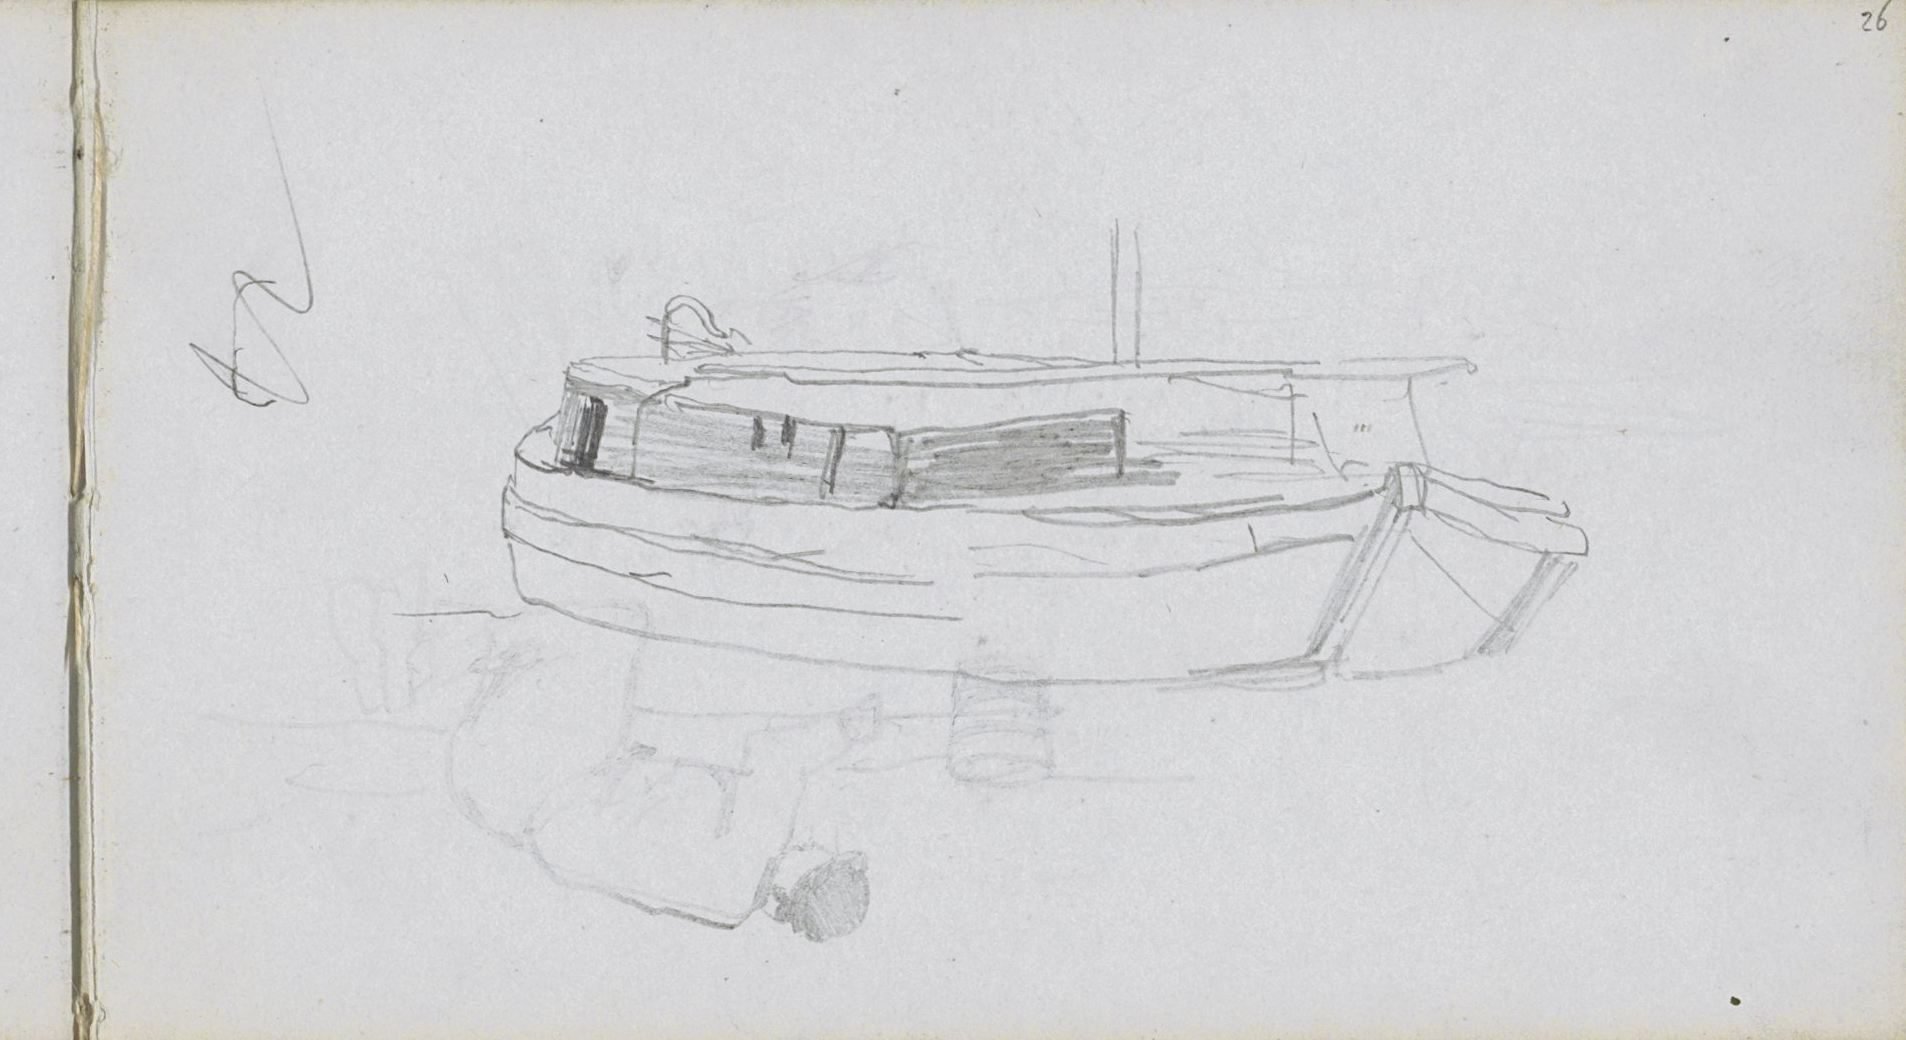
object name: sketchbook leaf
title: Boot en een knielende man bij een emmer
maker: johan hendrik weissenbruch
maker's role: draughtsman, painter, print maker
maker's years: 1824-1903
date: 1834-1903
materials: paper, pencil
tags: kneeling figure (+ male human being (not to be used where -a- is prescribed)), rowing-boat, canoe, etc.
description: Blad 26 recto uit een schetsboek met 39 bladen.